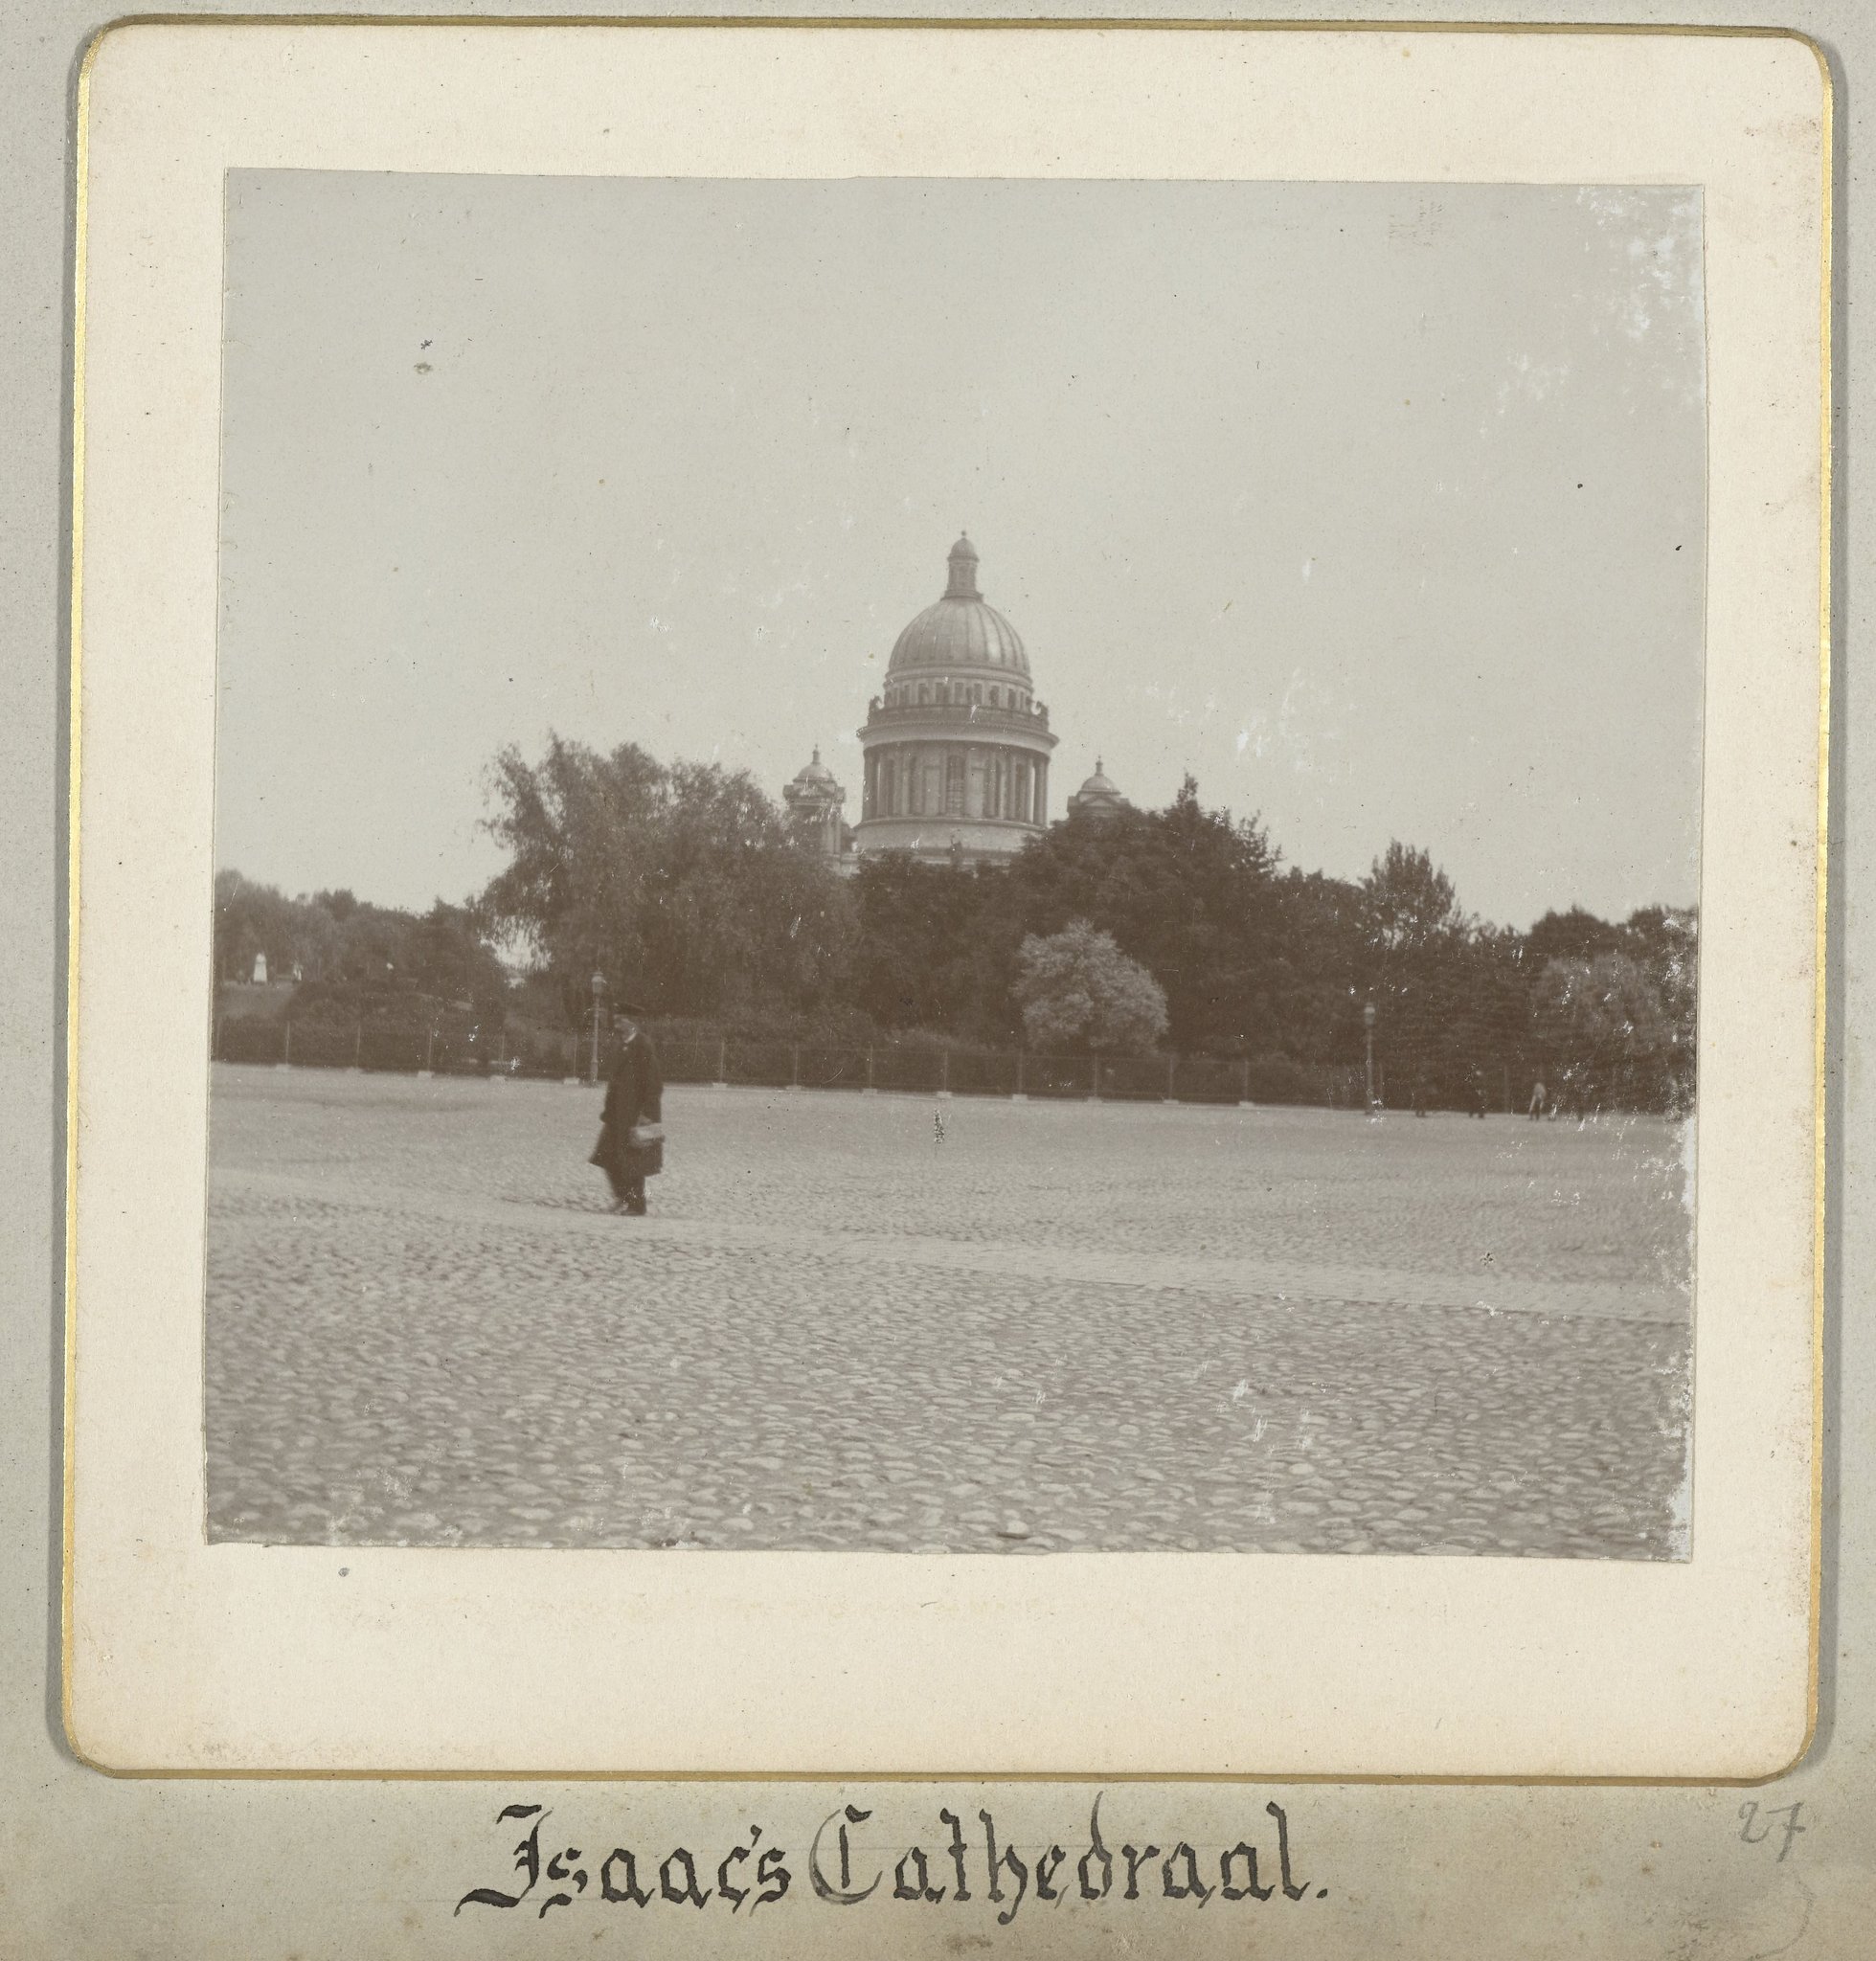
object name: photograph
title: Koepel van de Sint Isaac Kathedraal, ontworpen door Auguste Montferrand, Sint-Petersburg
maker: henry pauw van wieldrecht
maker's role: fotograaf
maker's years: 1863-1912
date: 1898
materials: paper, photographic support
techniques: albumen print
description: De koepel van Isaacs Kathedraal, ontworpen door Auguste Montferrand, tegenwoordig een museum.